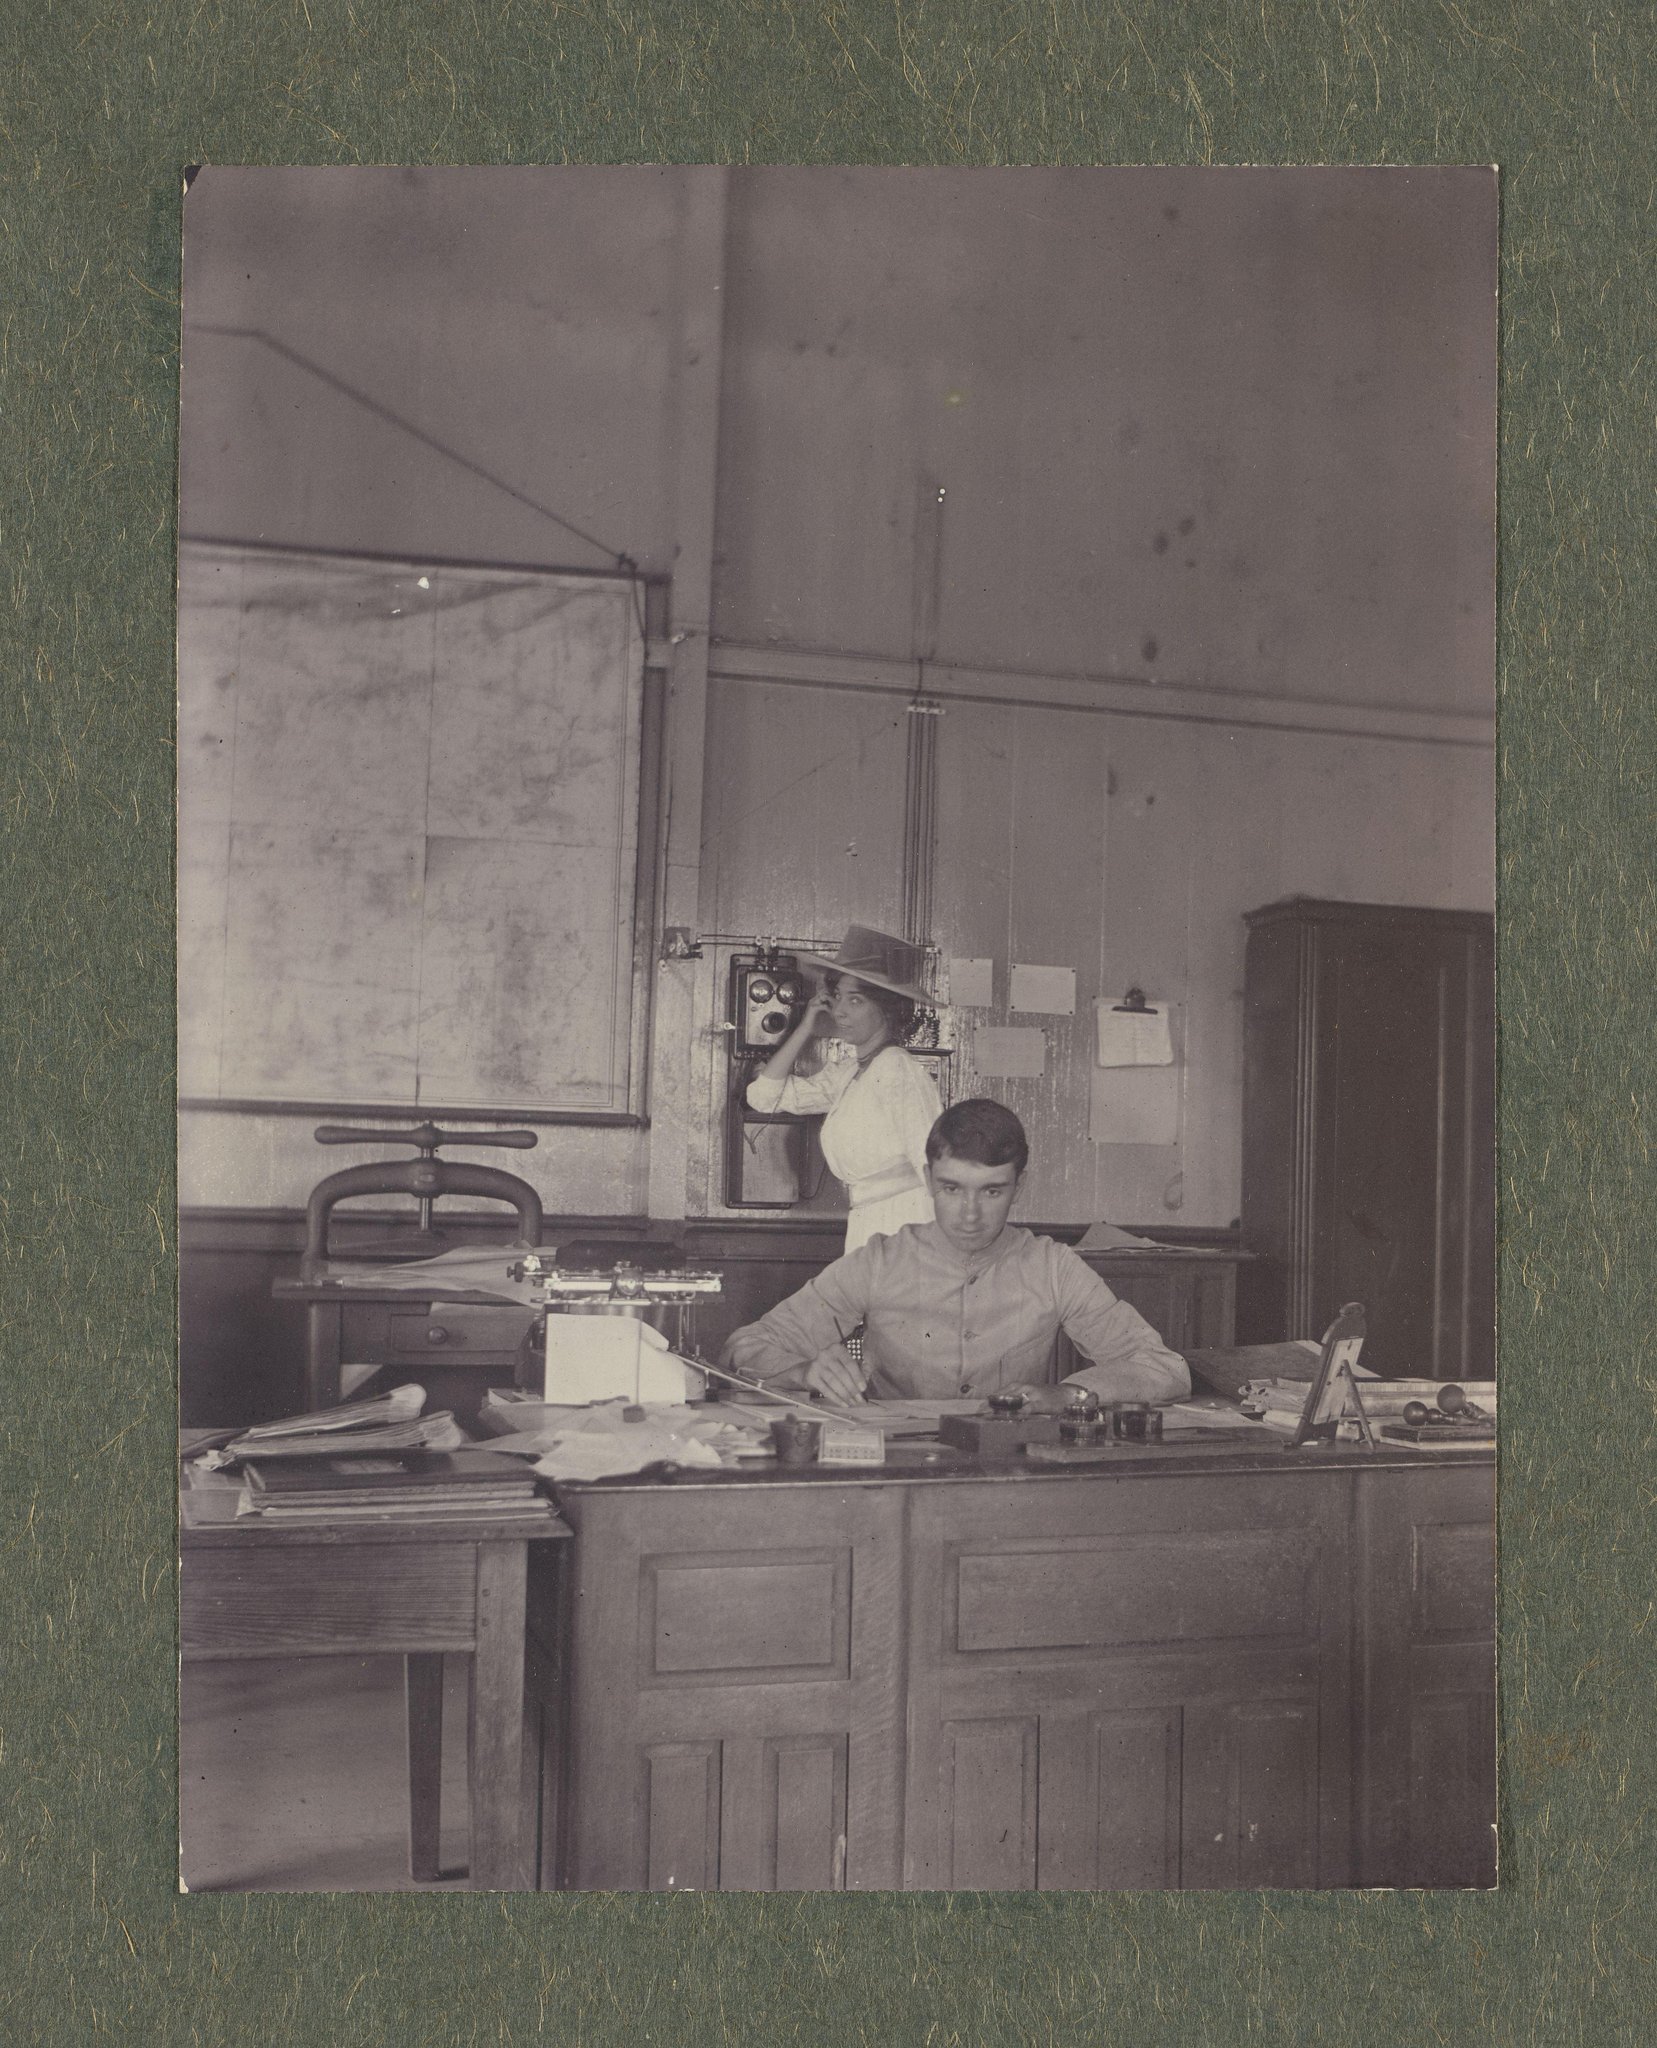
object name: photograph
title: Op Marienburg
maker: Anonymous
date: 1909-1910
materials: photographic support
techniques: gelatin silver print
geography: suriname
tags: suriname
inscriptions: inscription: ‘Marienburg’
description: Een vriendin van Maria Gonggrijp poseert aan de telefoon in een kantoor op Plantage Mariënburg. Onderdeel van het Lloyd fotoalbum van de familie Gonggrijp in de jaren 1909-1910.